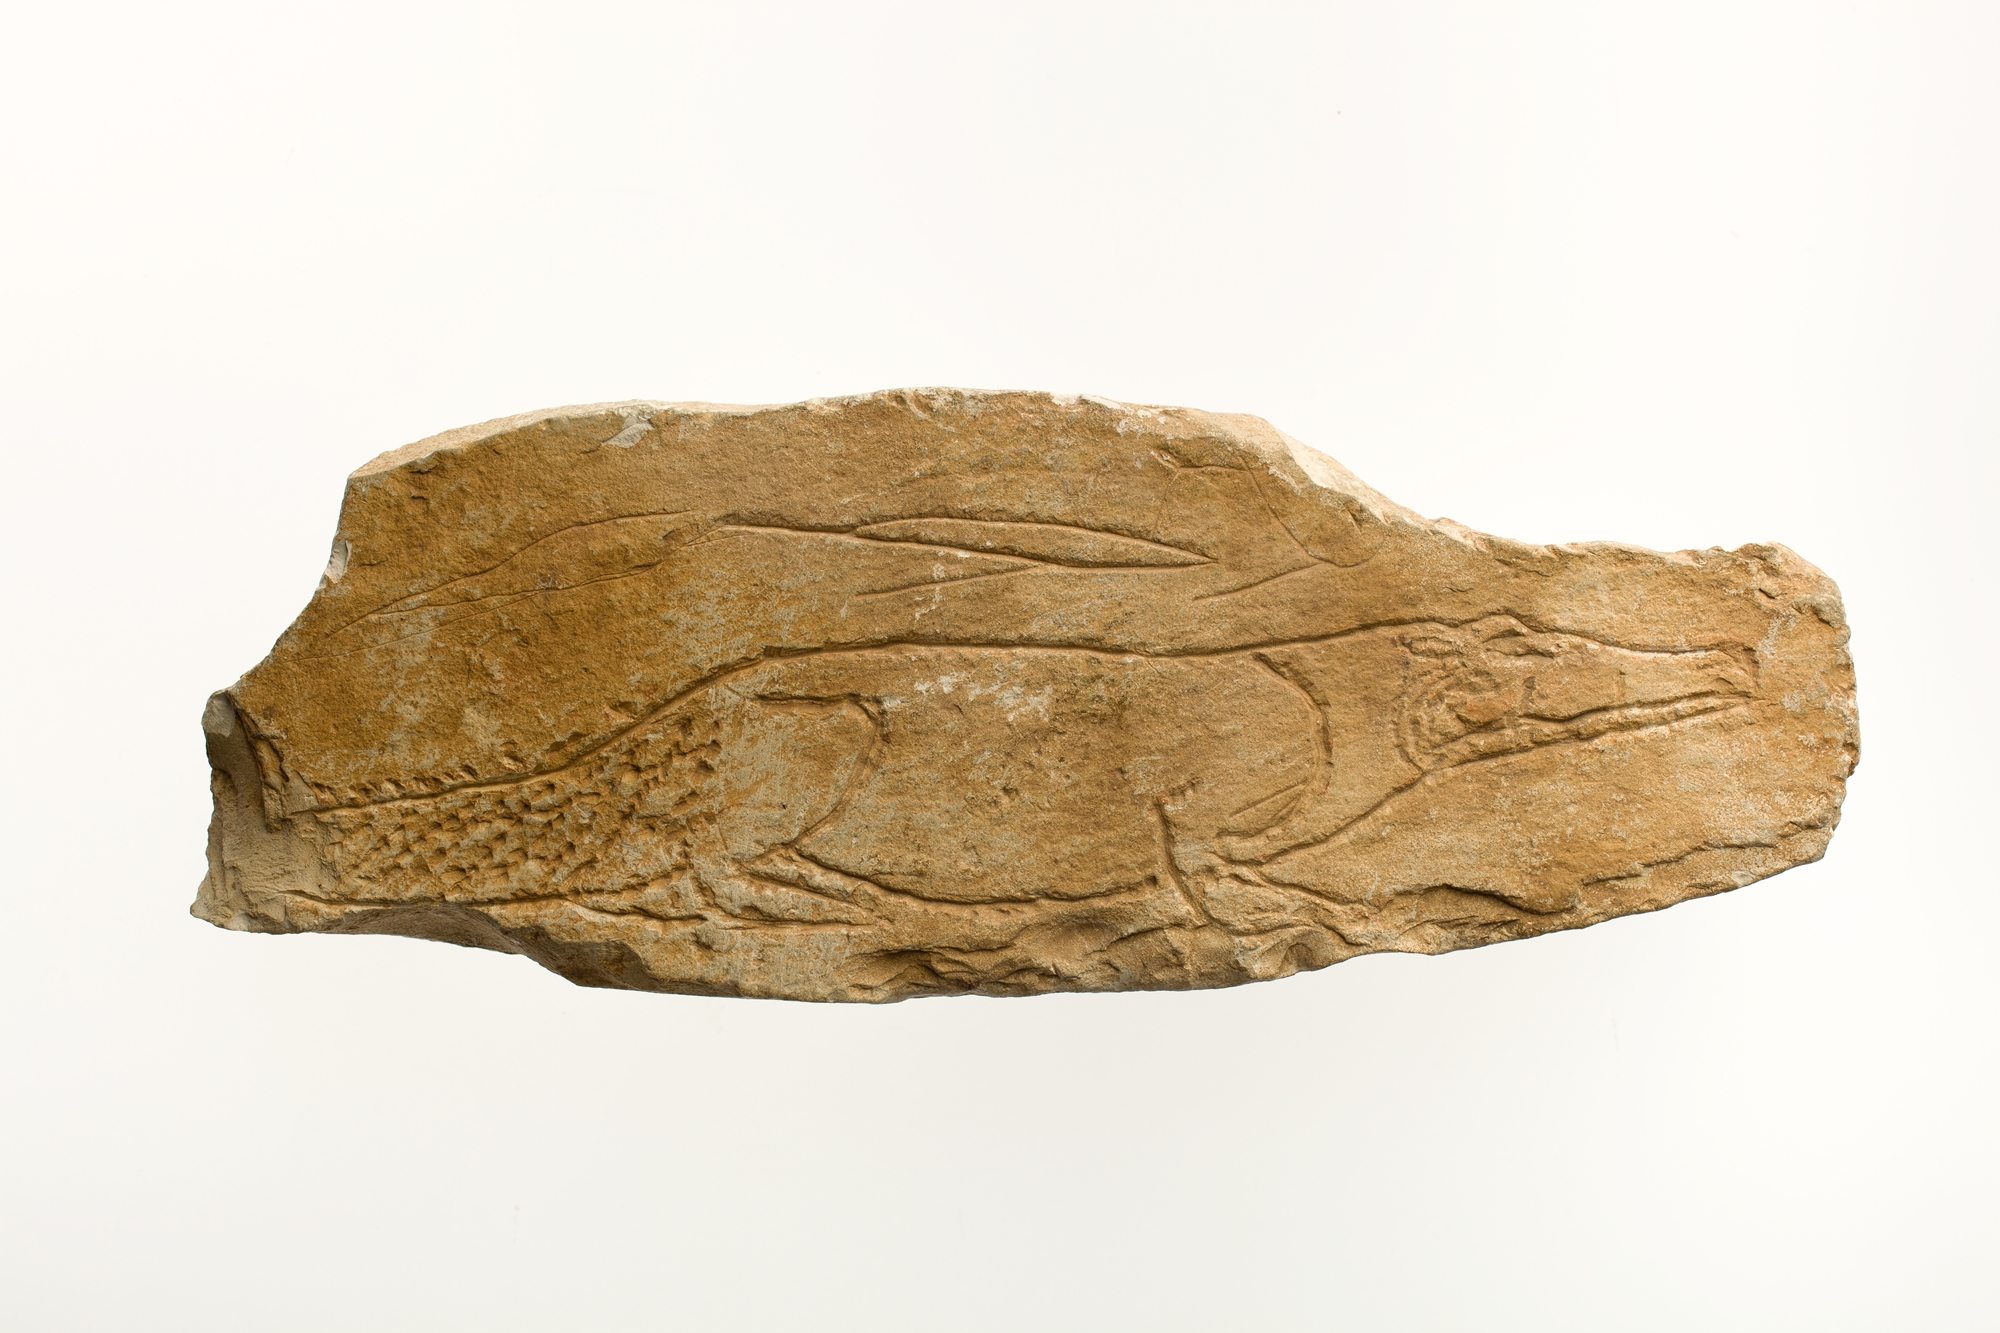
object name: ostracon, figured, crocodile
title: Ostracon with sketch of a crocodile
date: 332-330 BCE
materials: ink, limestone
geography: egypt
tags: crocodiles